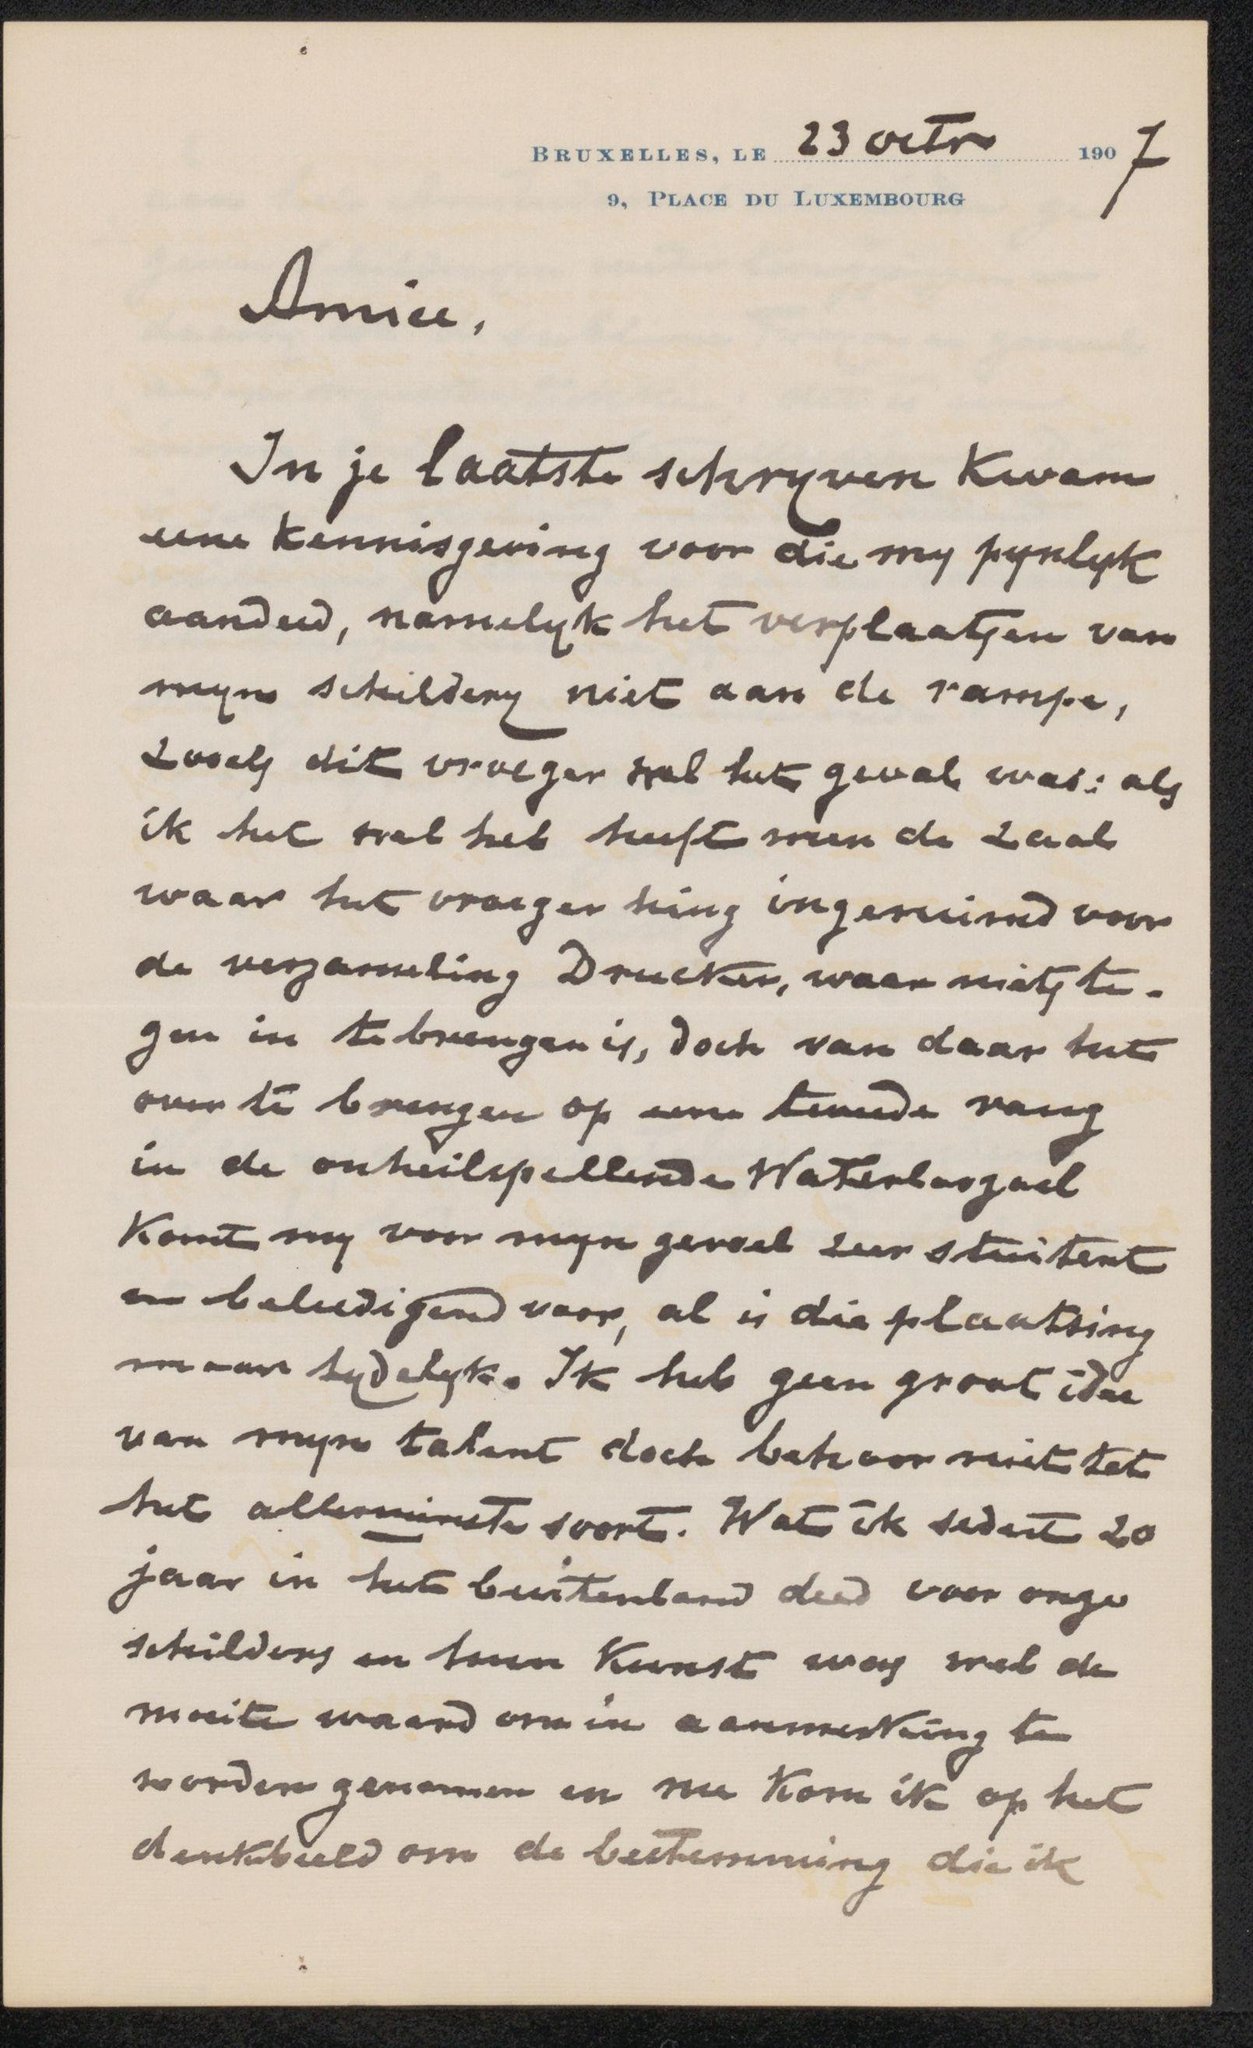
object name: letter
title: Brief aan August Allebé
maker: johannes hubertus leonardus de haas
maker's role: draughtsman, painter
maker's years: 1832-1908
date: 1907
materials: ink, paper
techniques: pen, printing, writing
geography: brussels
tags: amsterdam, print maker, august allebé, painting (including book-illumination, miniature-painting), exhibition ~ art, art collecting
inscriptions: watermark